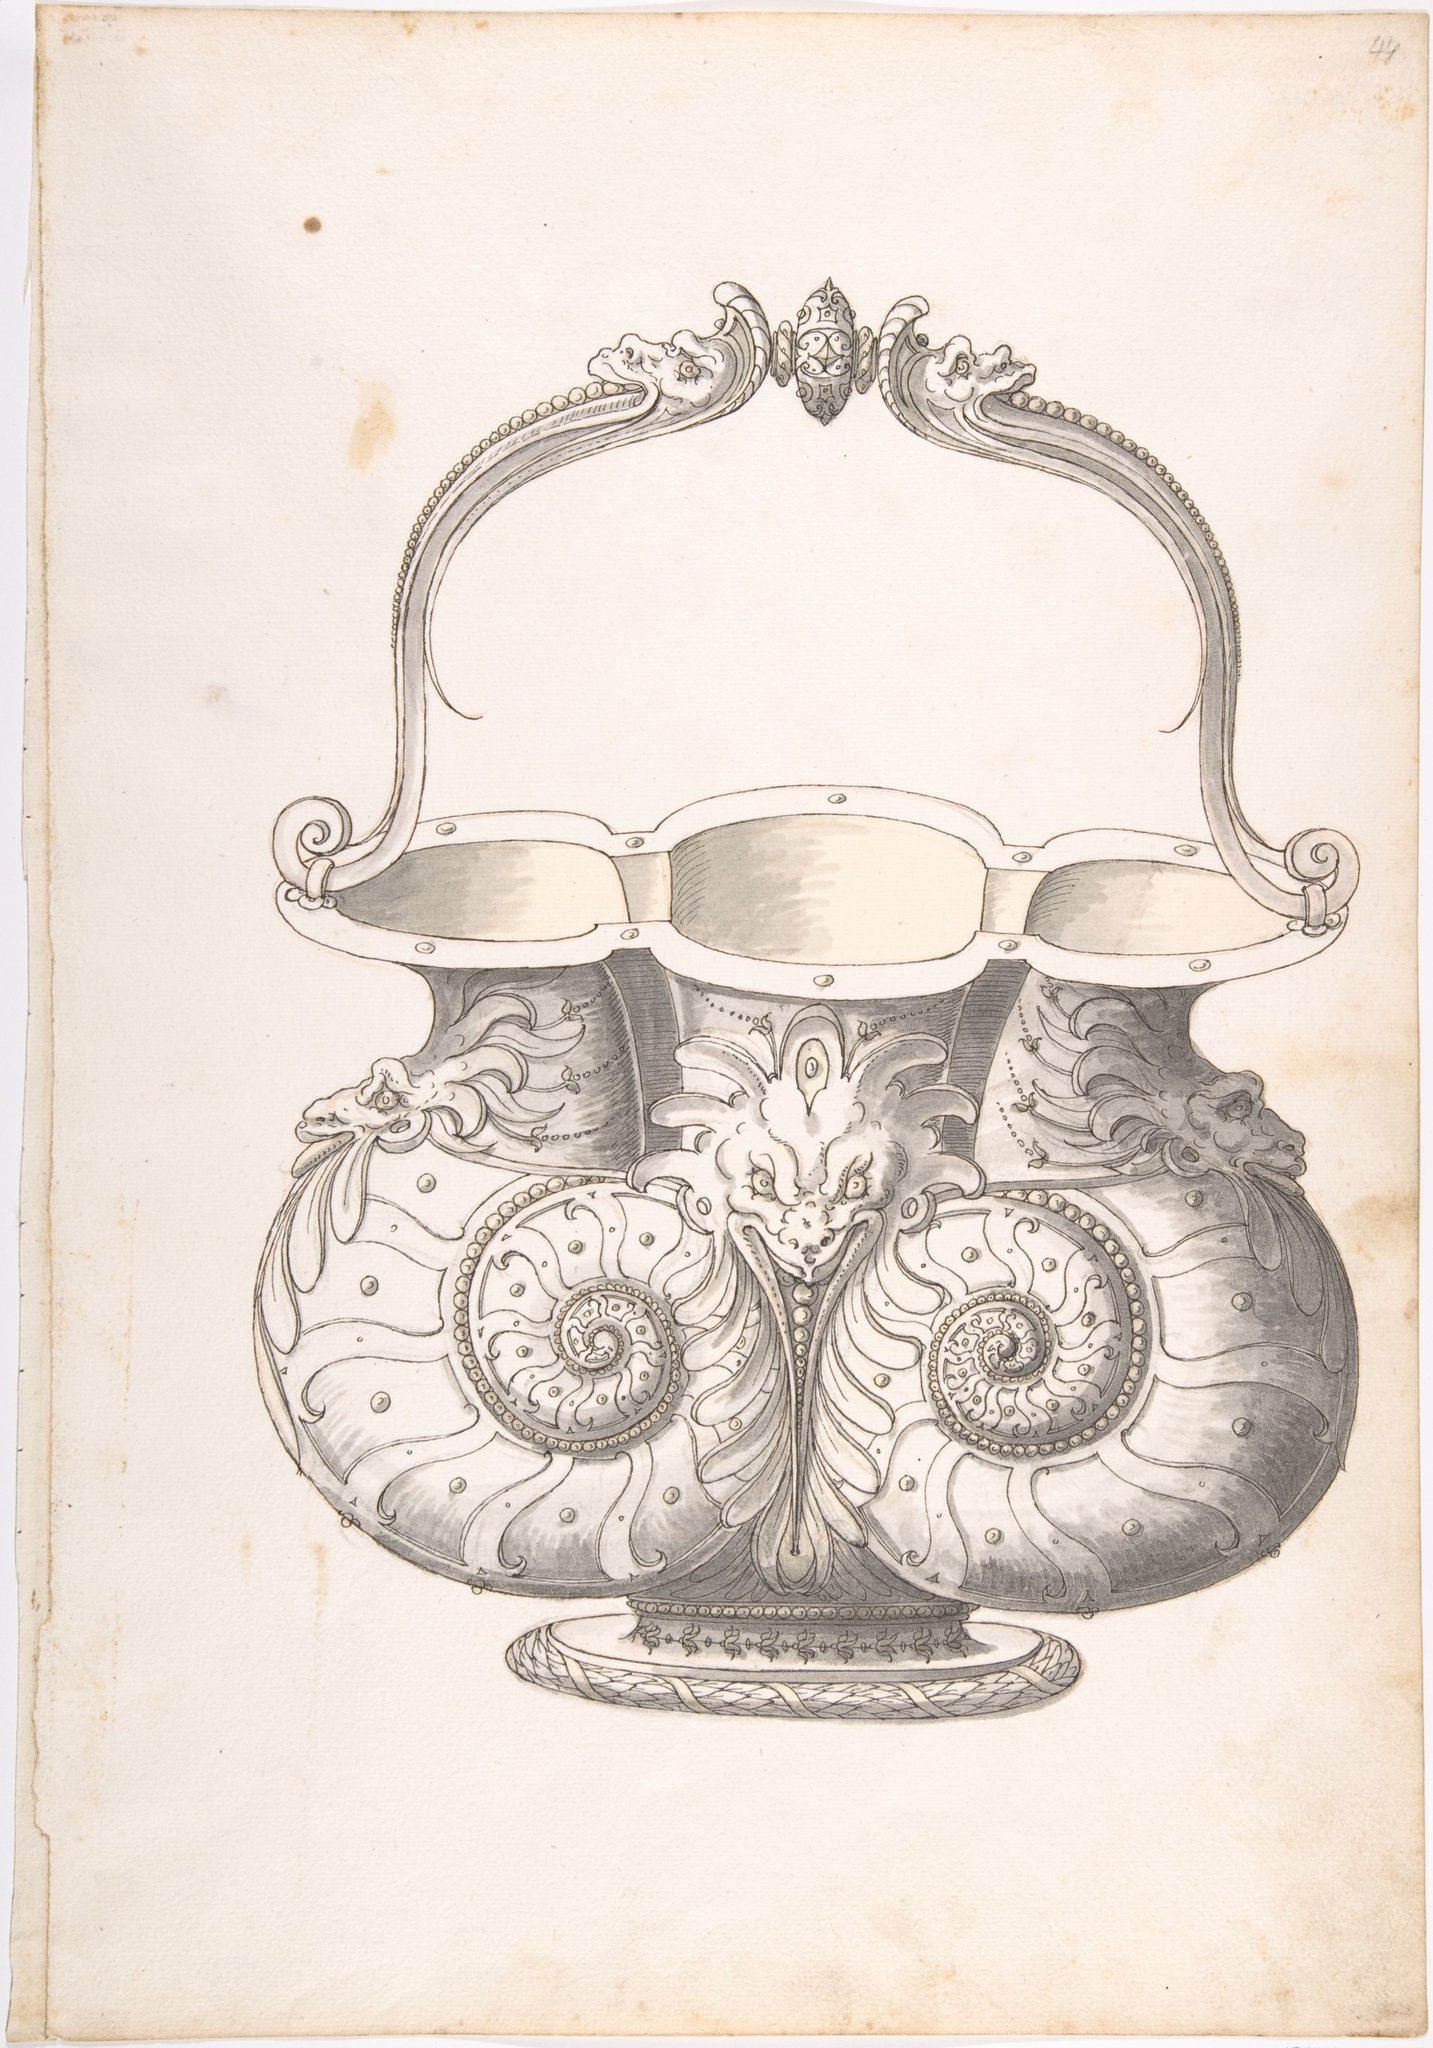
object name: drawing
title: Design for a Bucket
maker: erasmus hornick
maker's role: artist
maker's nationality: netherlandish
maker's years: 1501-1583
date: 1501-1600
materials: chalk, ink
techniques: brush, pen, wash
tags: buckets